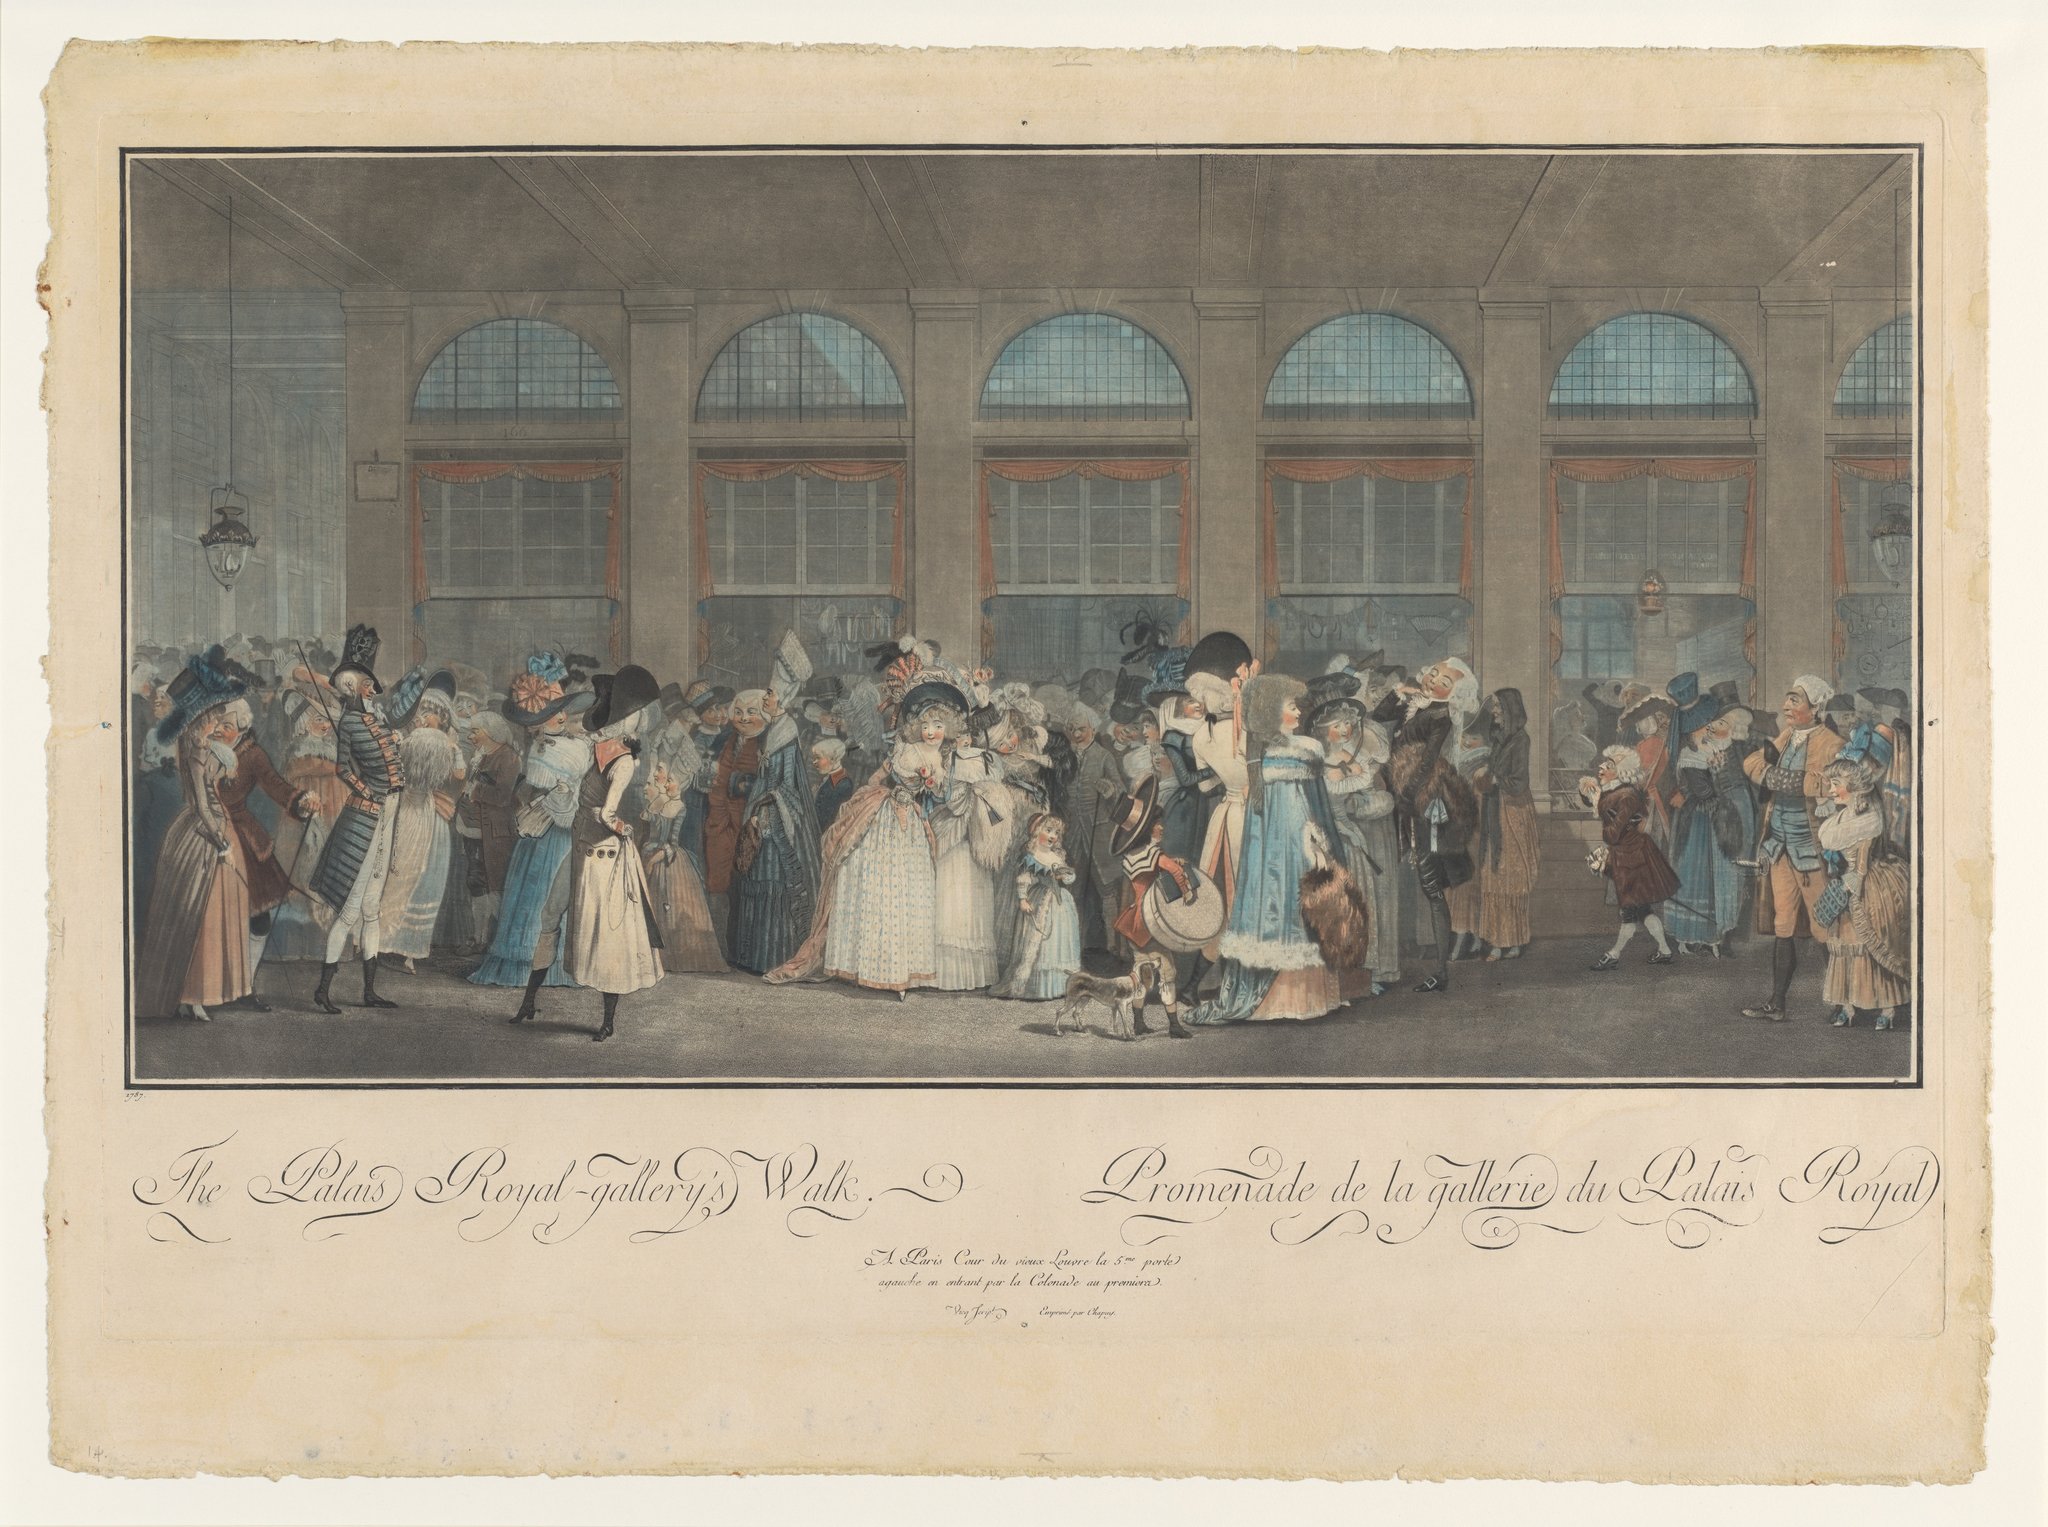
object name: print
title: The Palais Royal-Gallery's Walk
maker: louis philibert debucourt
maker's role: artist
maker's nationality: french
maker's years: 1755-1832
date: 1787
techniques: engraving